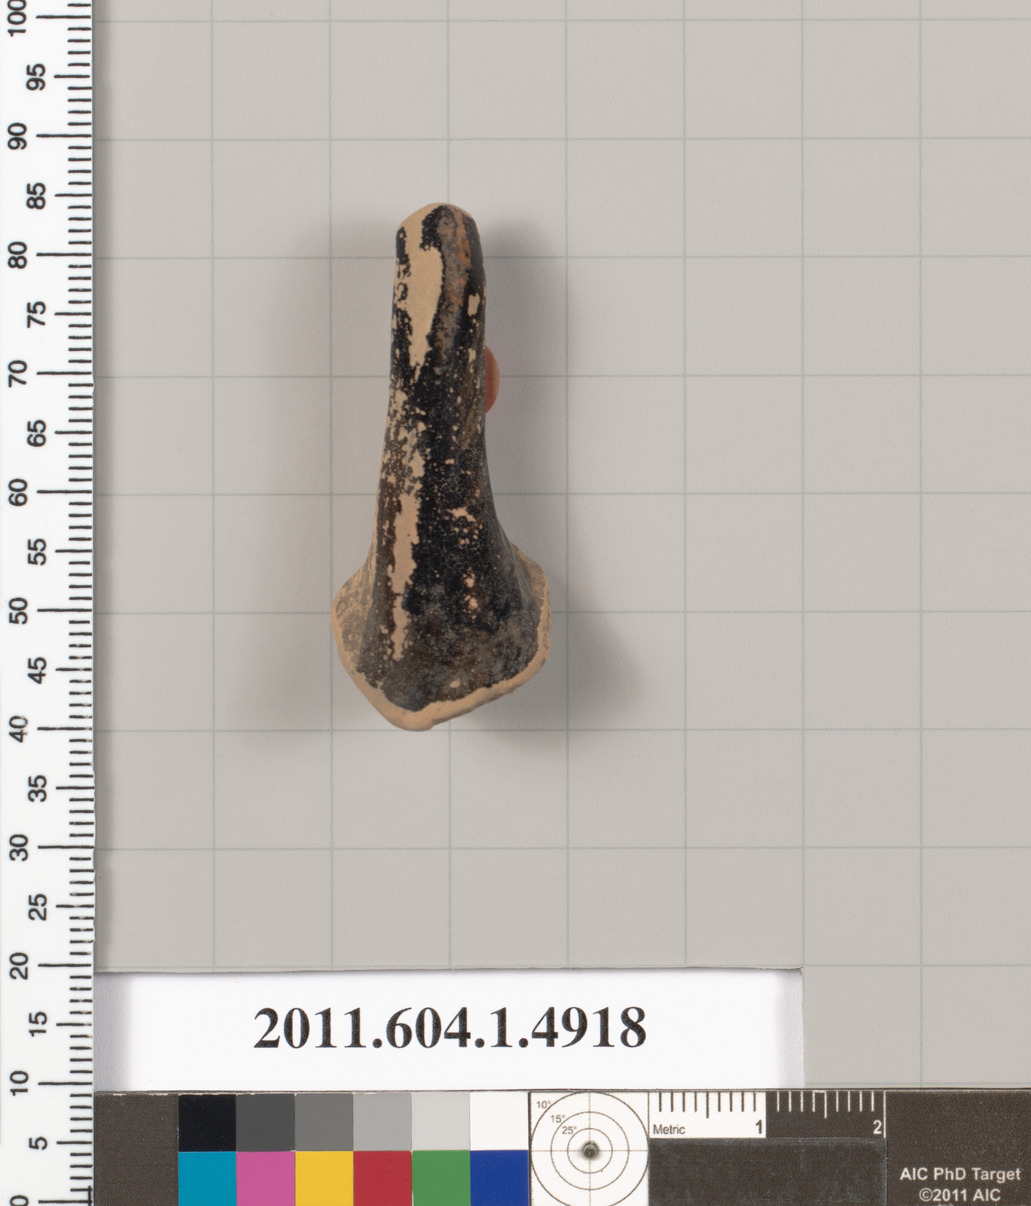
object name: kylix fragment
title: Terracotta fragment of a kylix (drinking cup)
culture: greek, attic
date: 500-401 BCE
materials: terracotta